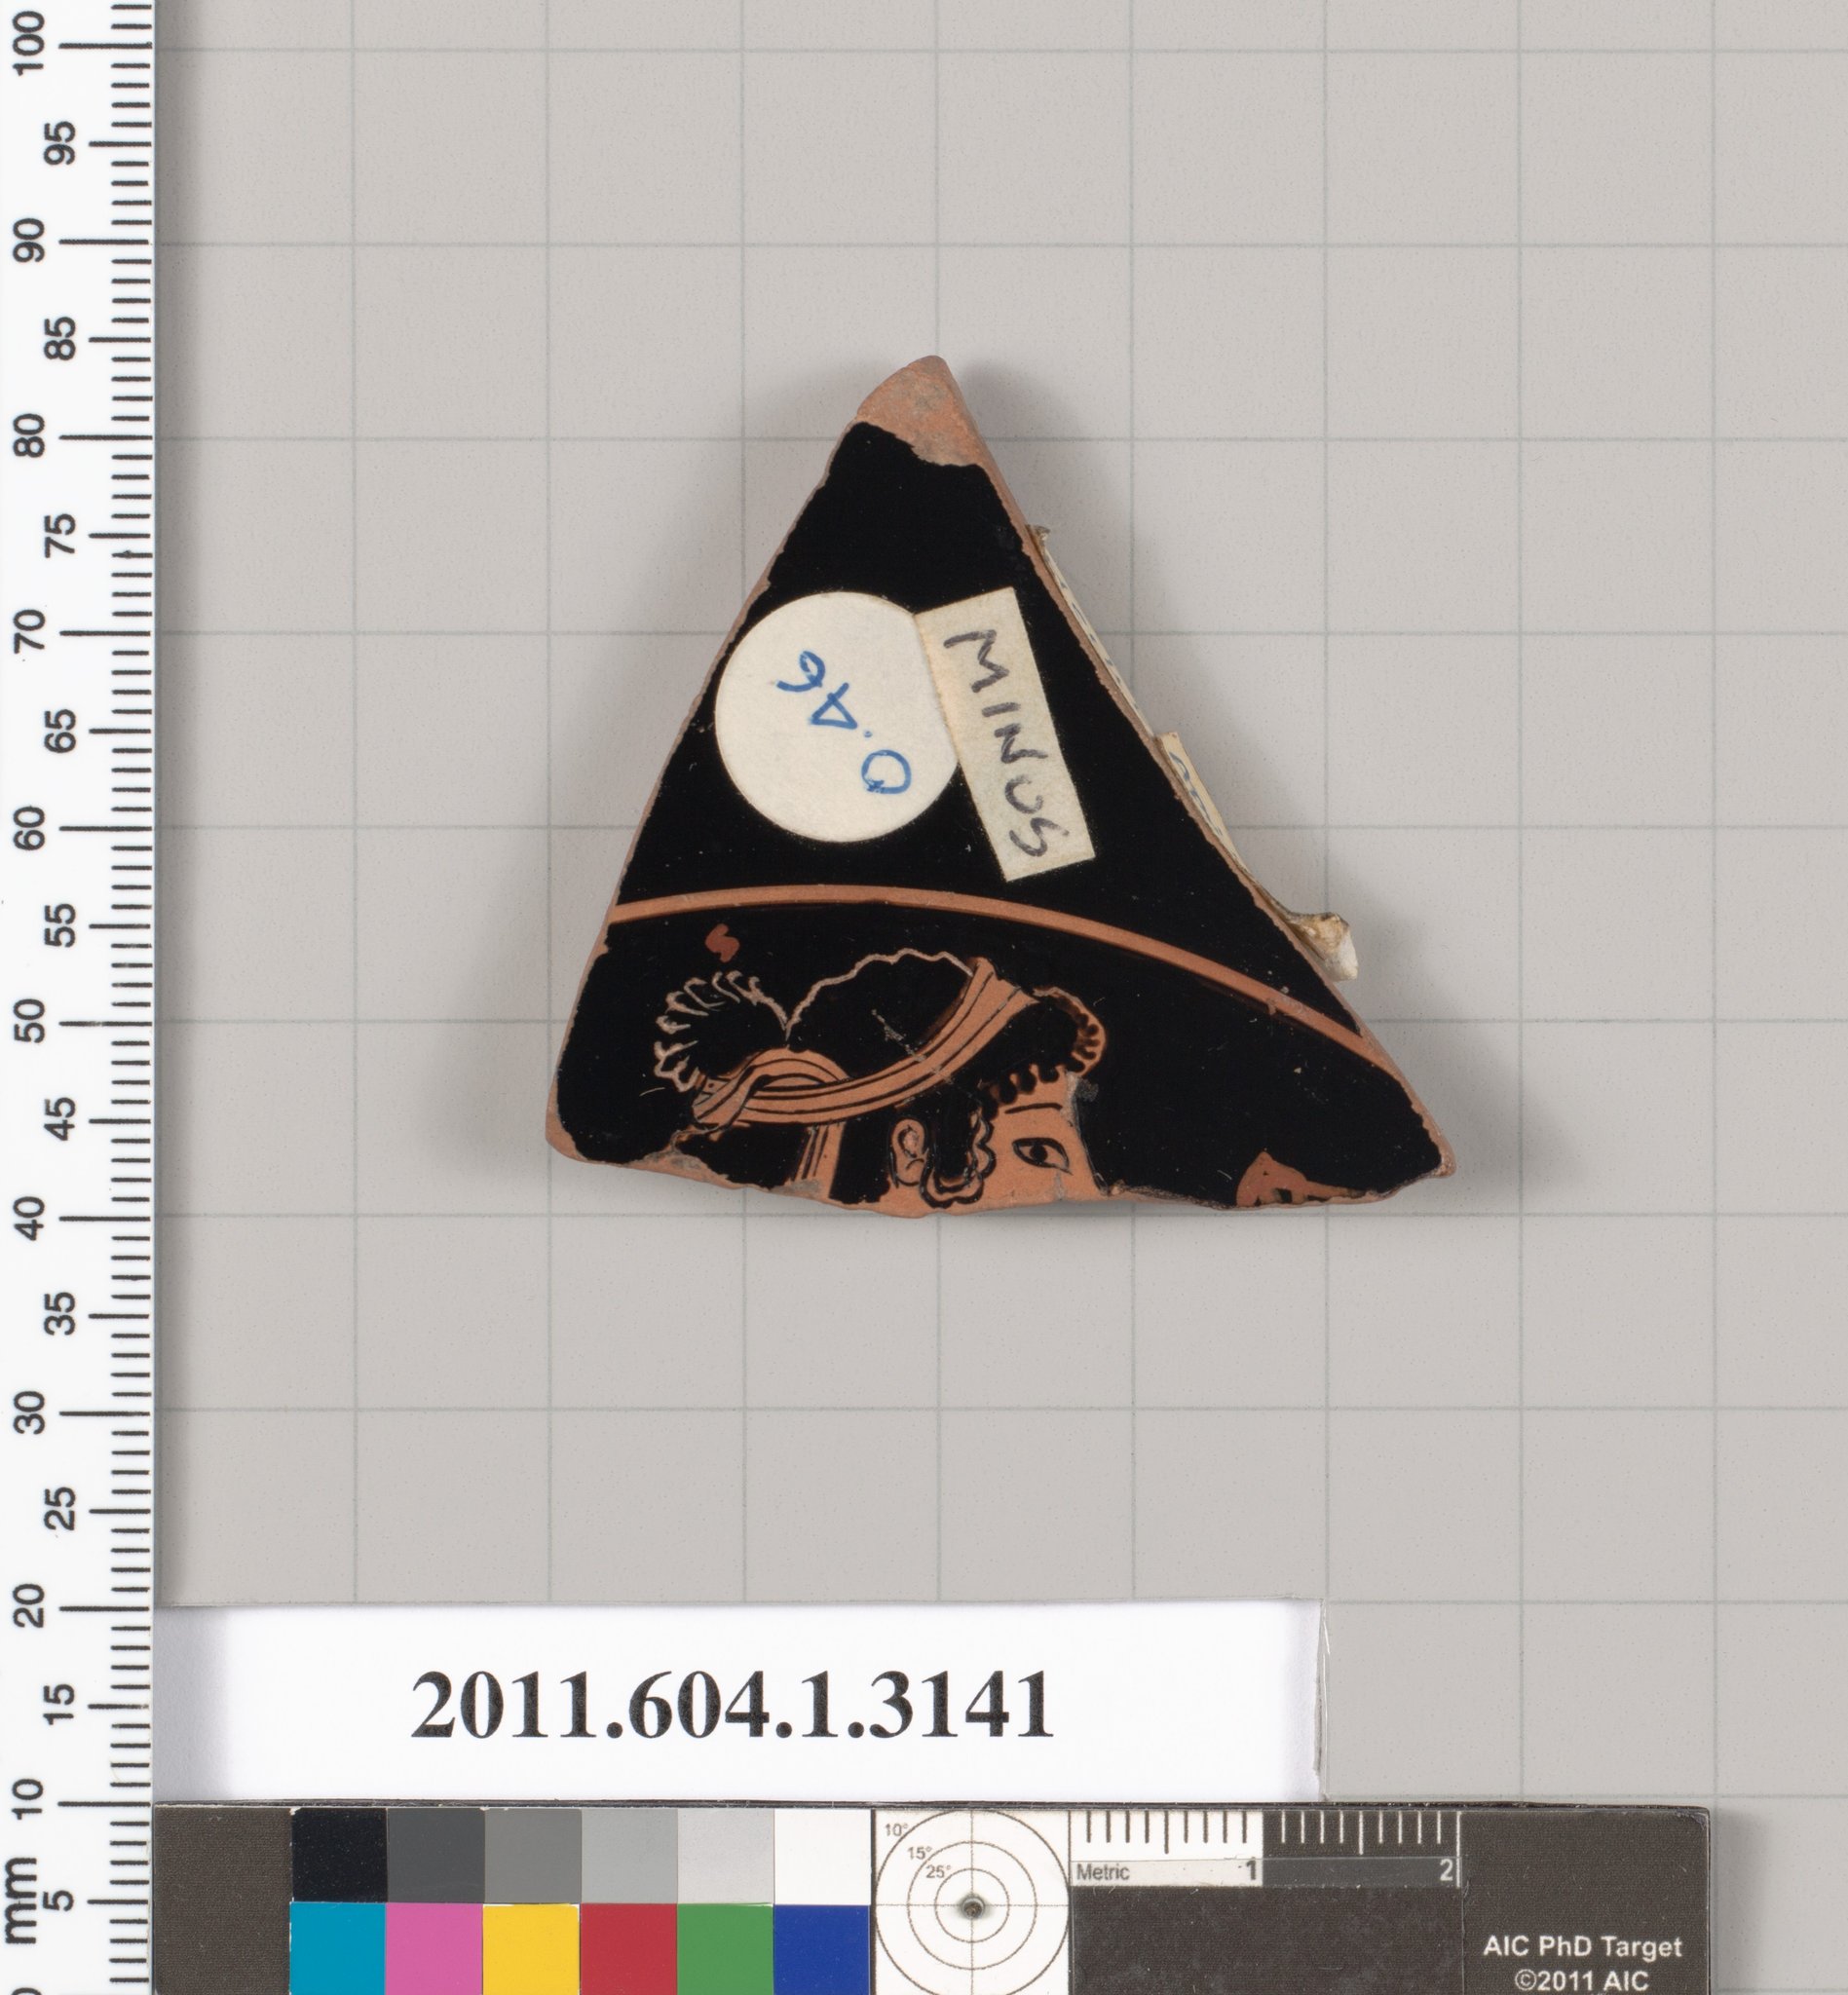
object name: kylix fragment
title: Terracotta fragment of a kylix (drinking cup)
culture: greek, attic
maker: thalia painter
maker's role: artist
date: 510-500 BCE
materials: terracotta